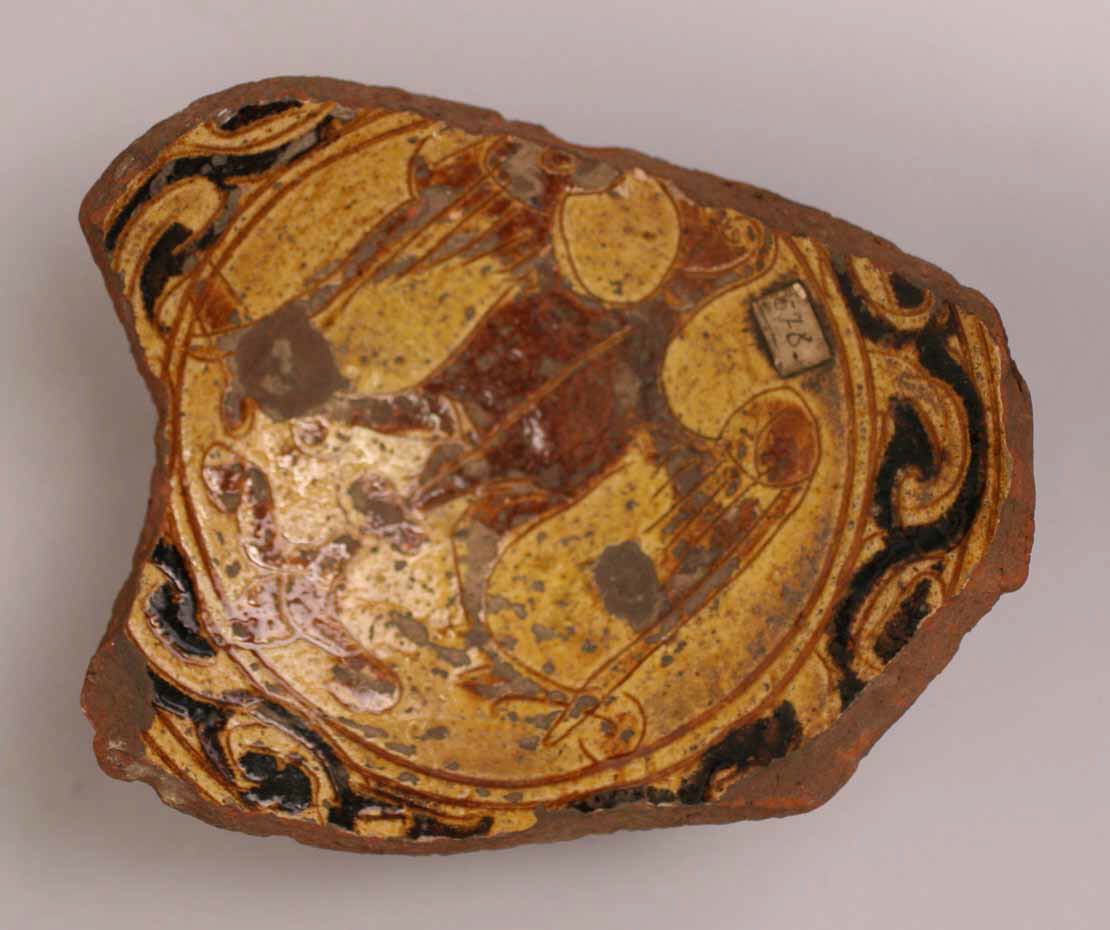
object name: fragment of a bowl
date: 1301-1400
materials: earthenware, glaze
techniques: coloring, incising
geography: egypt